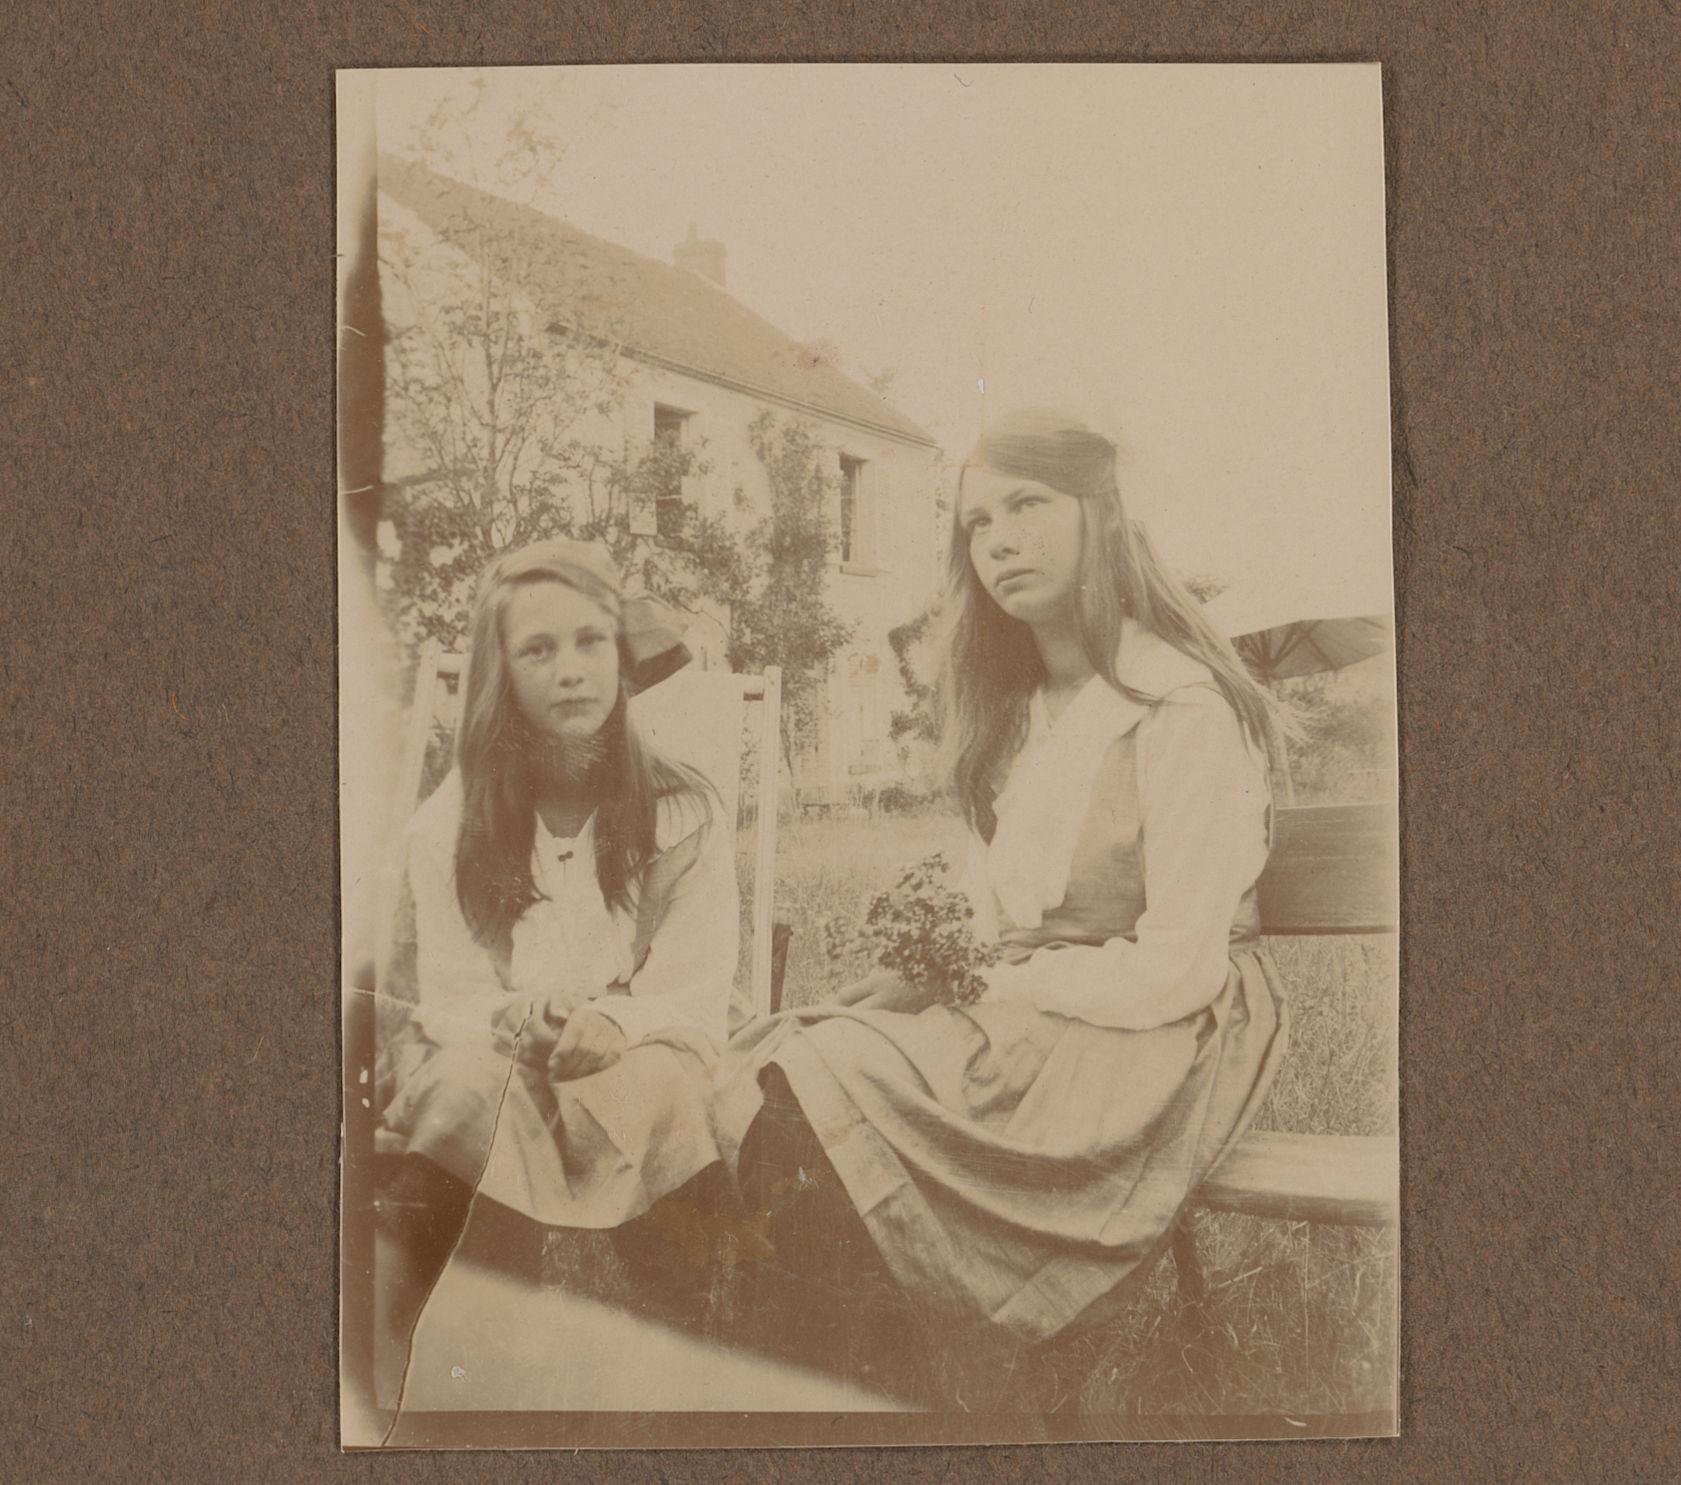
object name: photograph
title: Thea en Joanna Diepenbrock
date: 1908-1915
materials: photographic support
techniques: photography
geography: netherlands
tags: amsterdam, netherlands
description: Foto op bruin albumblad 49 van familiealbum van Alphons Diepenbrock.